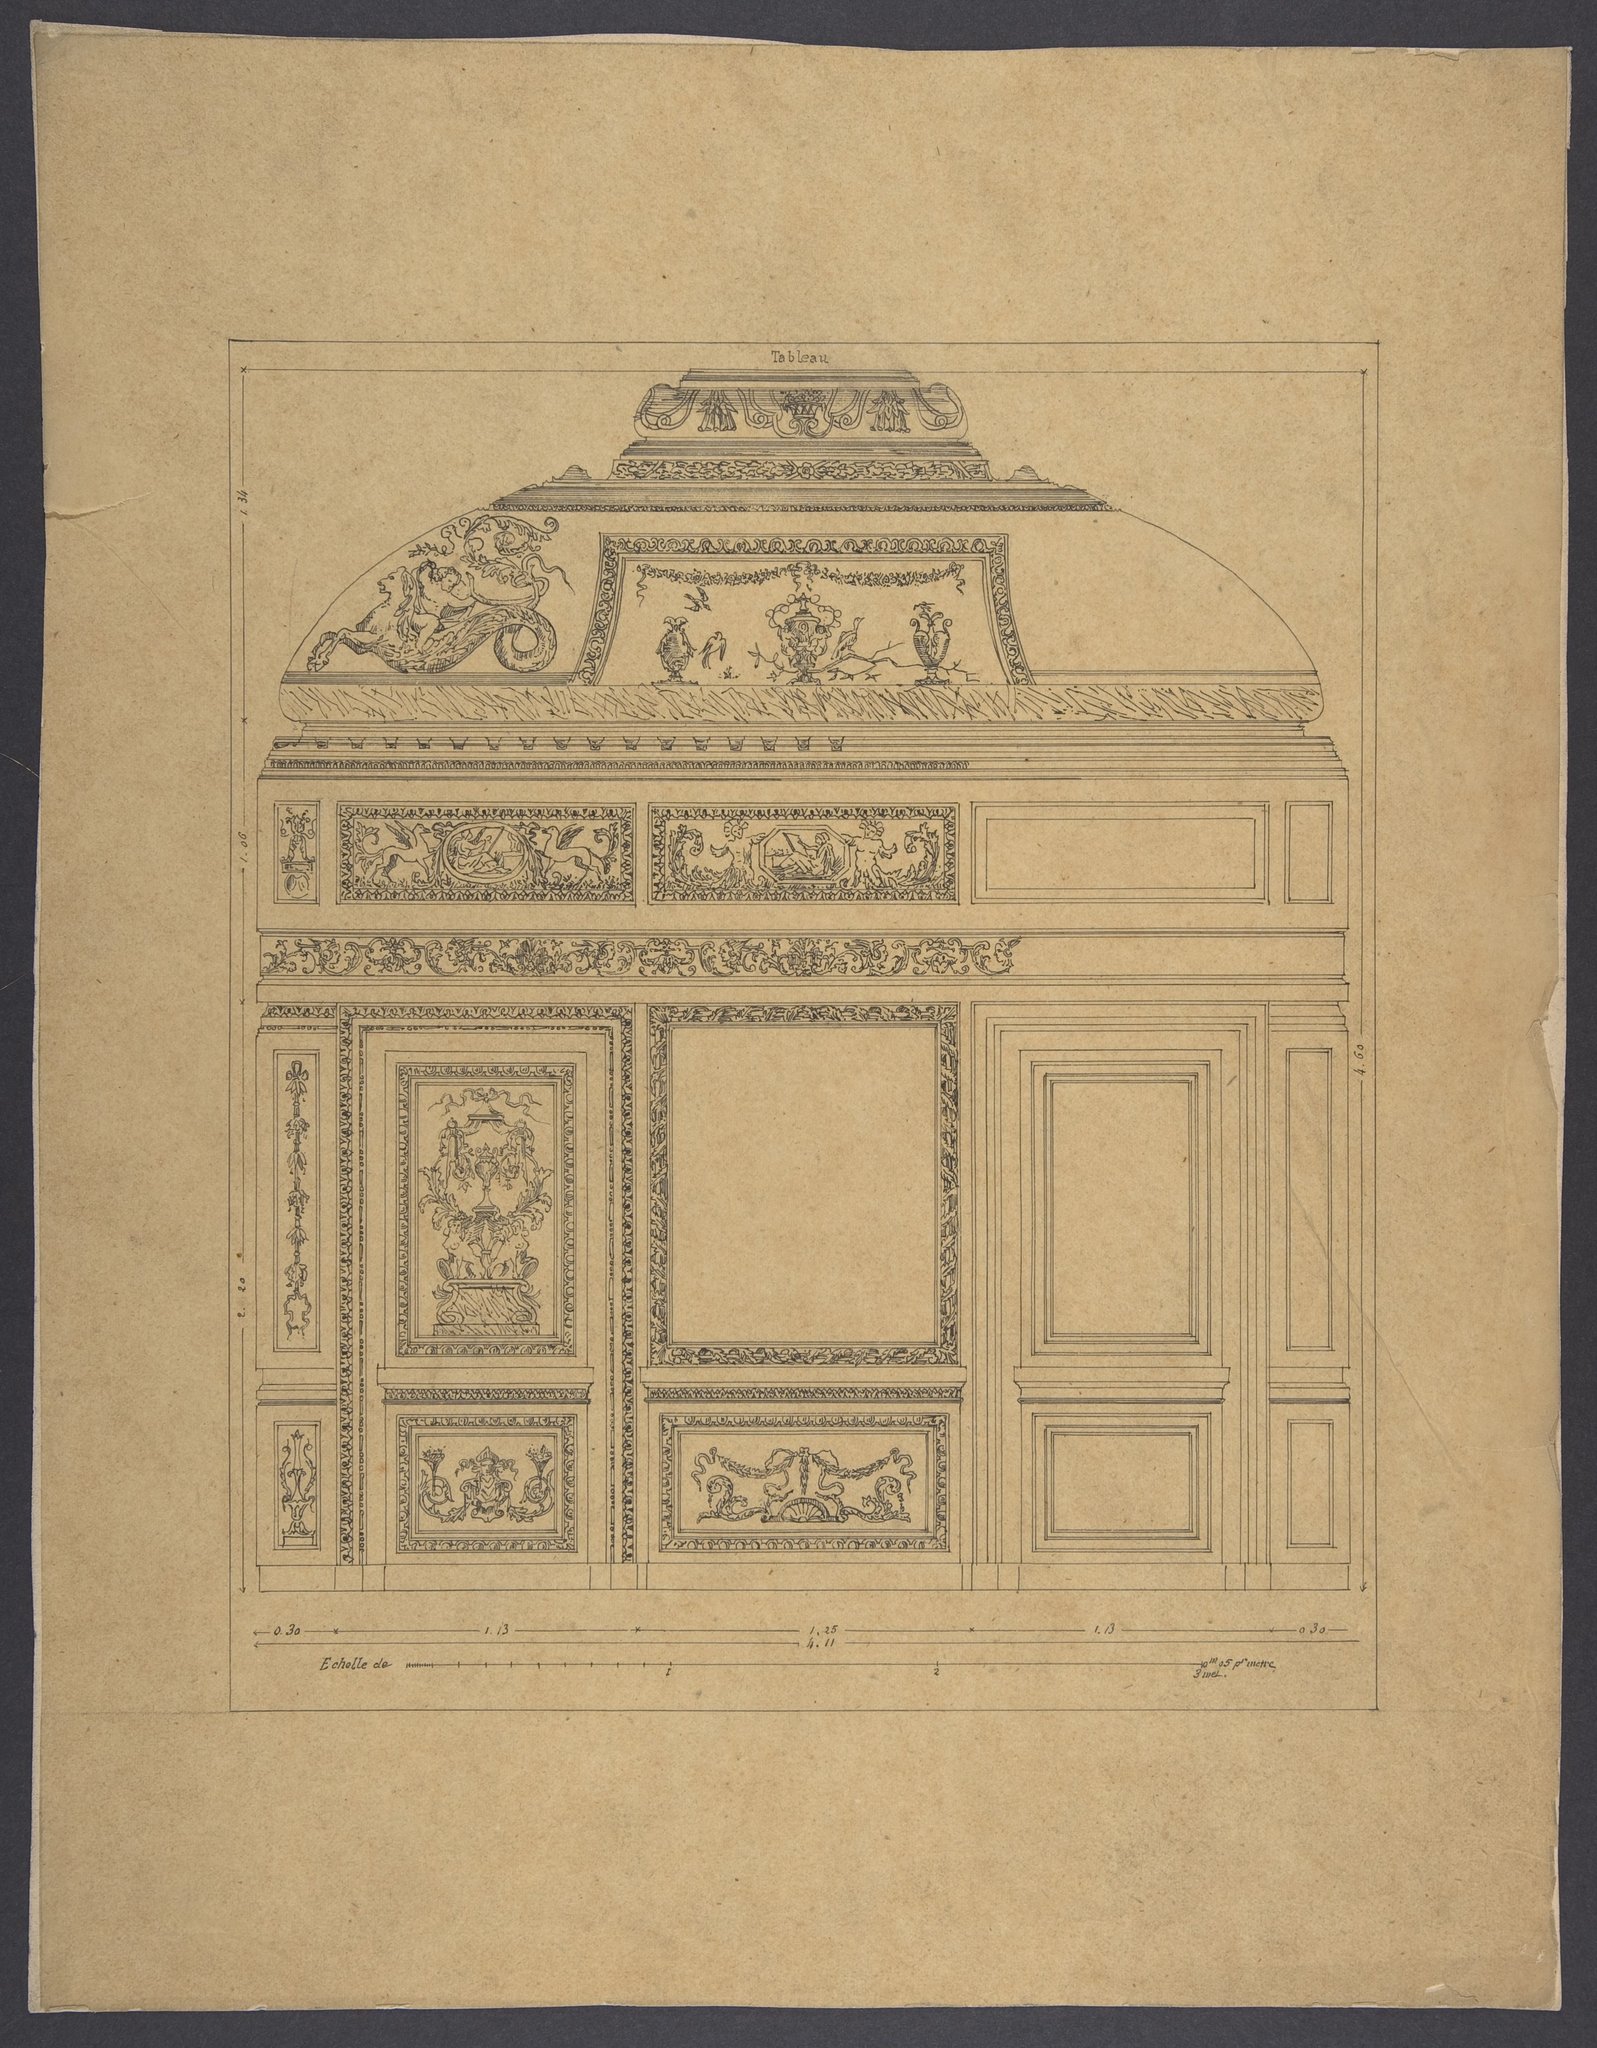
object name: drawing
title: Boiserie from the Hôtel Colbert de Villacerf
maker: anonymous, french, 19th century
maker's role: artist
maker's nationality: french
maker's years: 1800-1900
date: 1801-1900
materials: ink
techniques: pen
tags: architecture